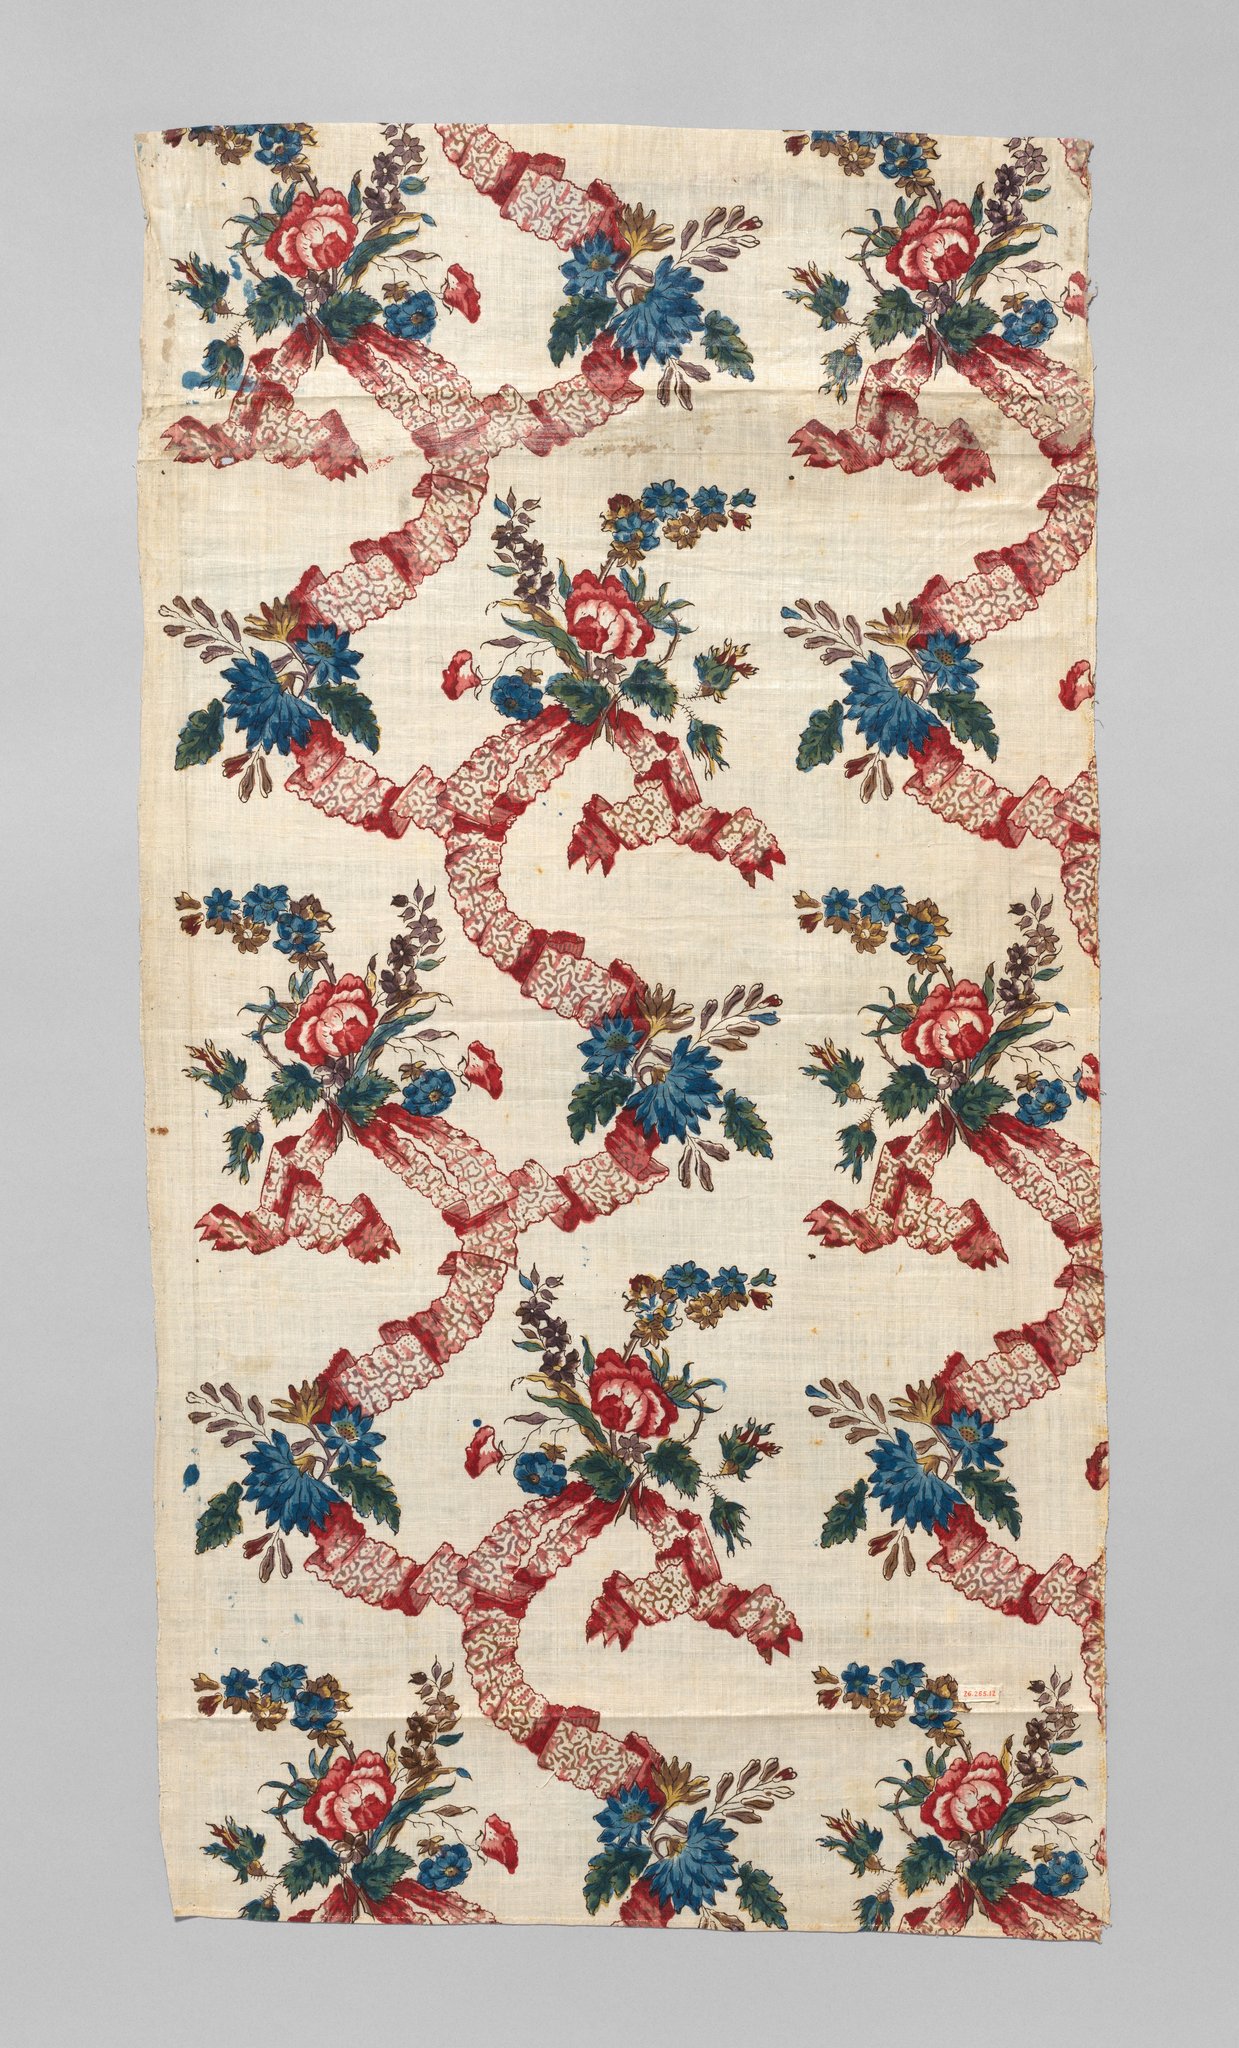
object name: piece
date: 1831-1851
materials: cotton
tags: flowers